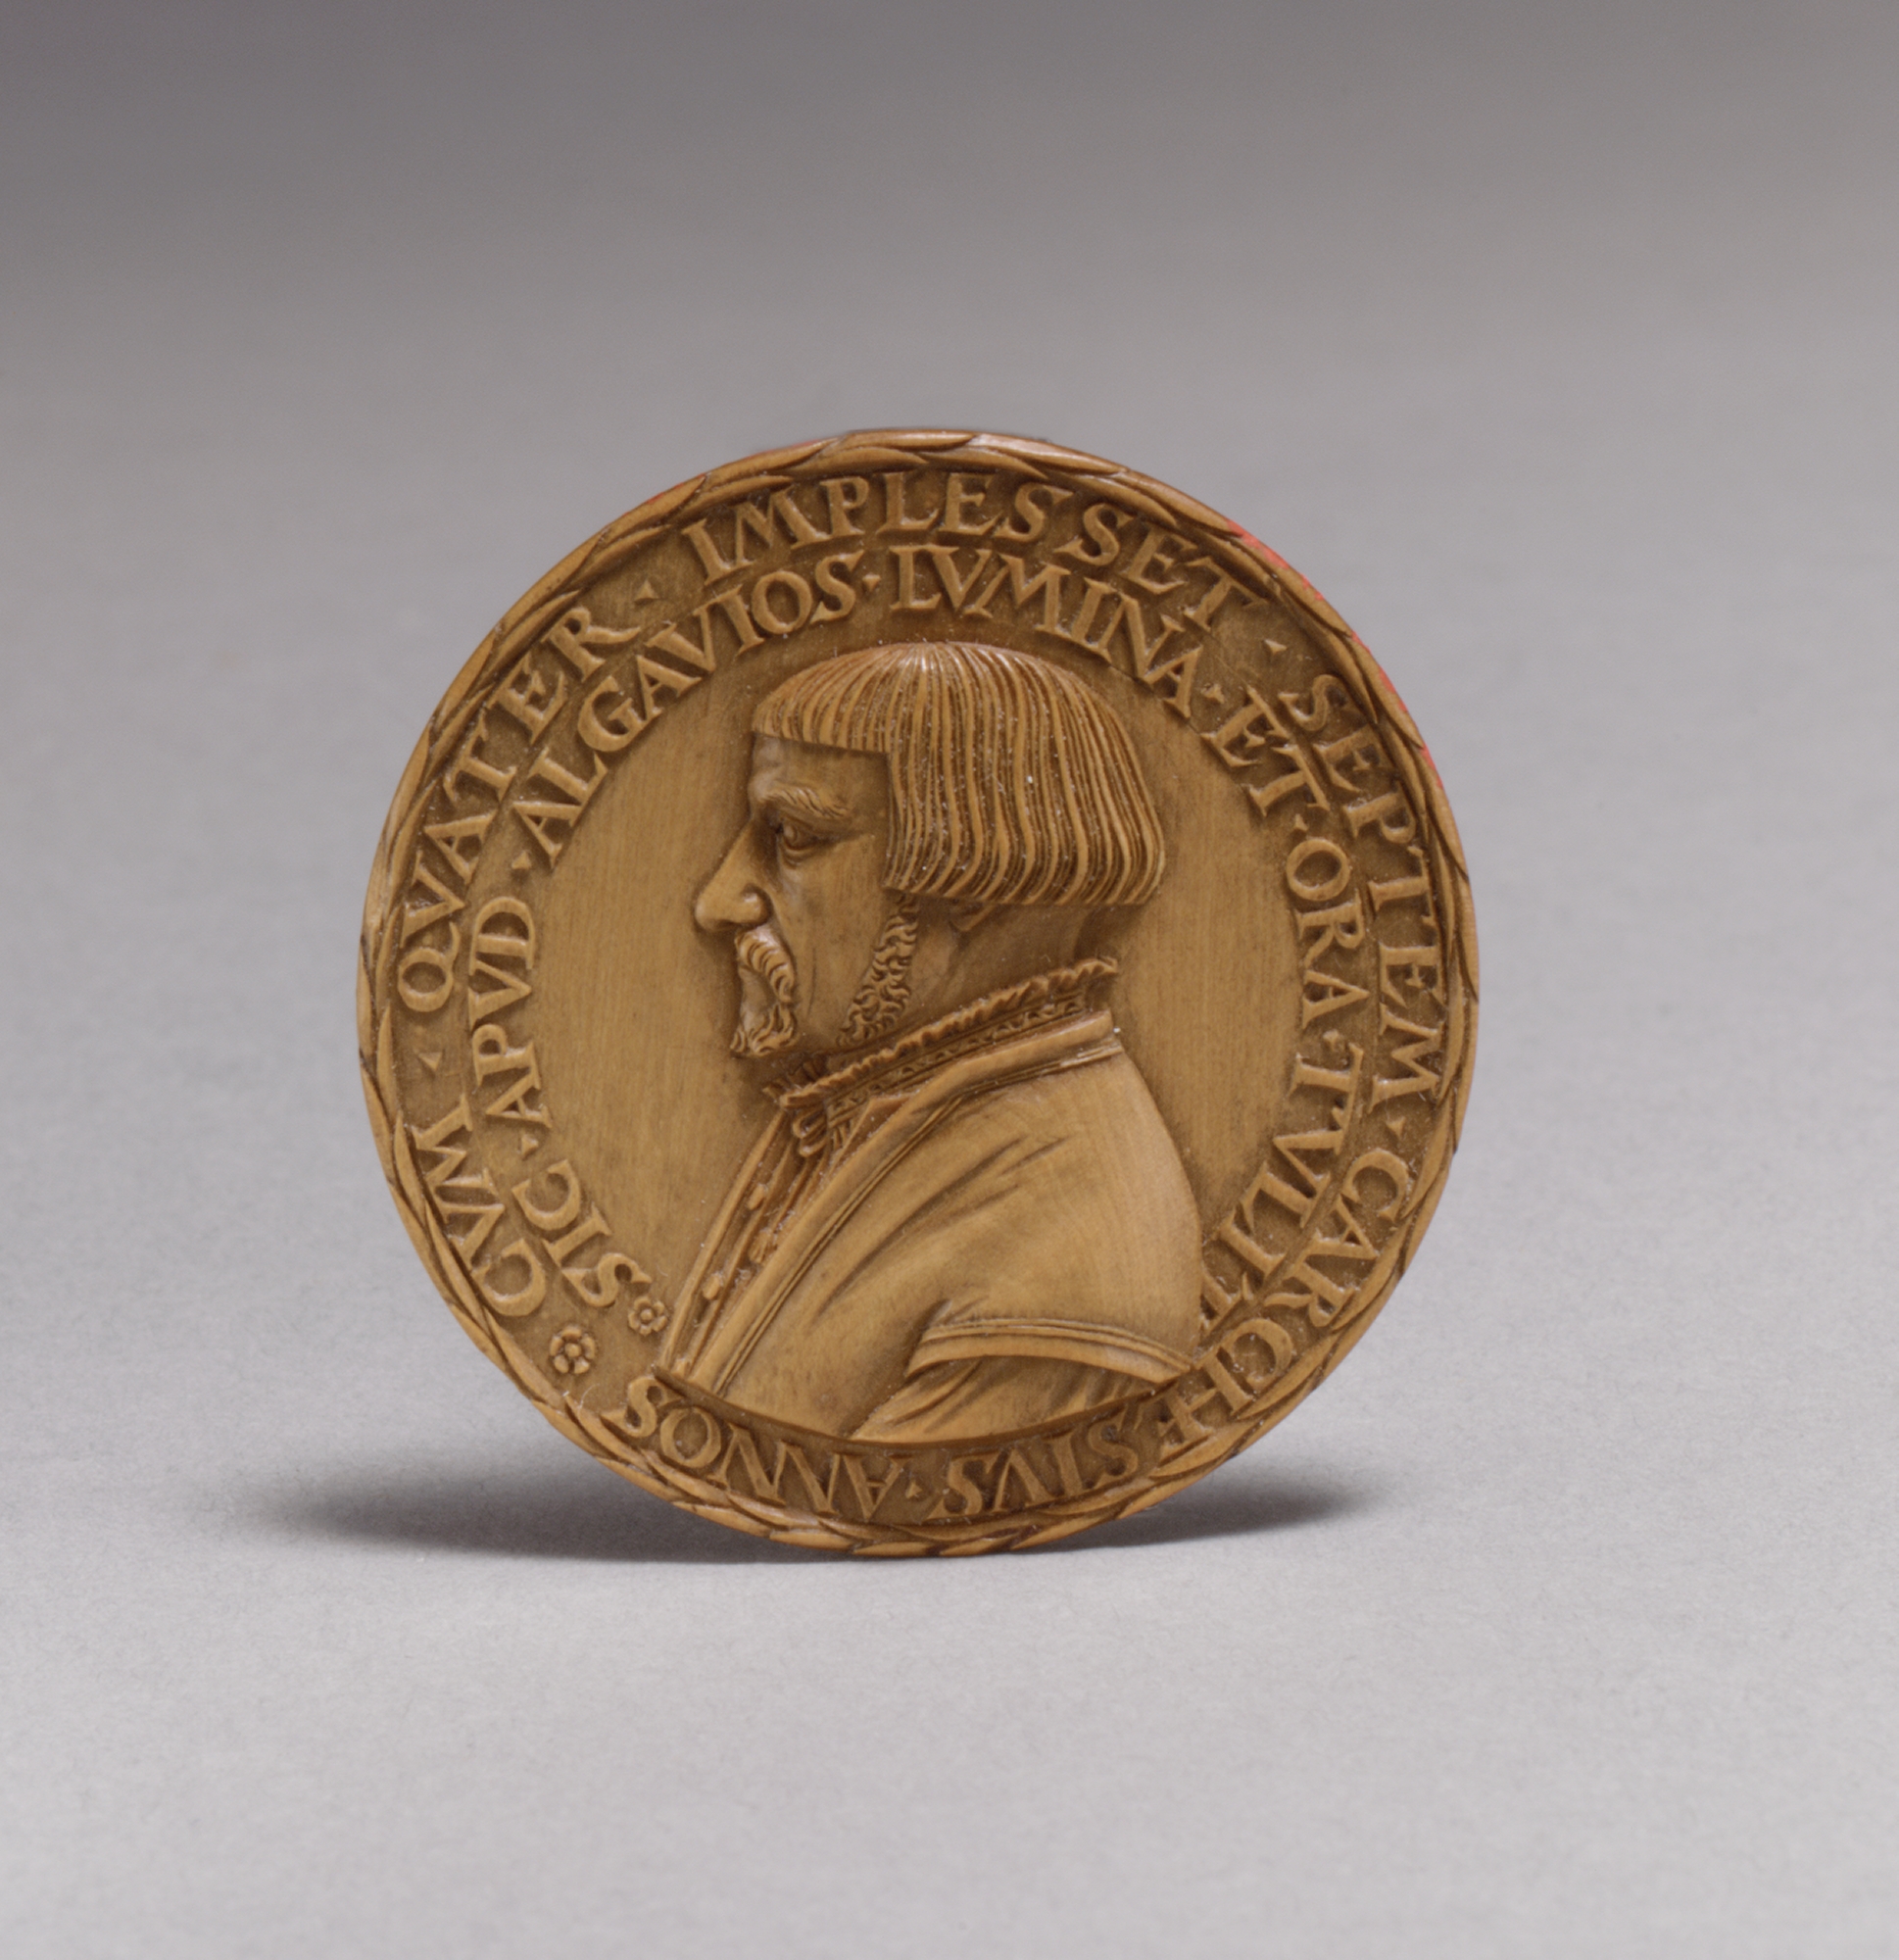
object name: medallion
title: Carchesius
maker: hans kels the younger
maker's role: artist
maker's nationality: german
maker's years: 1508-1565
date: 1541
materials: wood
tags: men,profiles